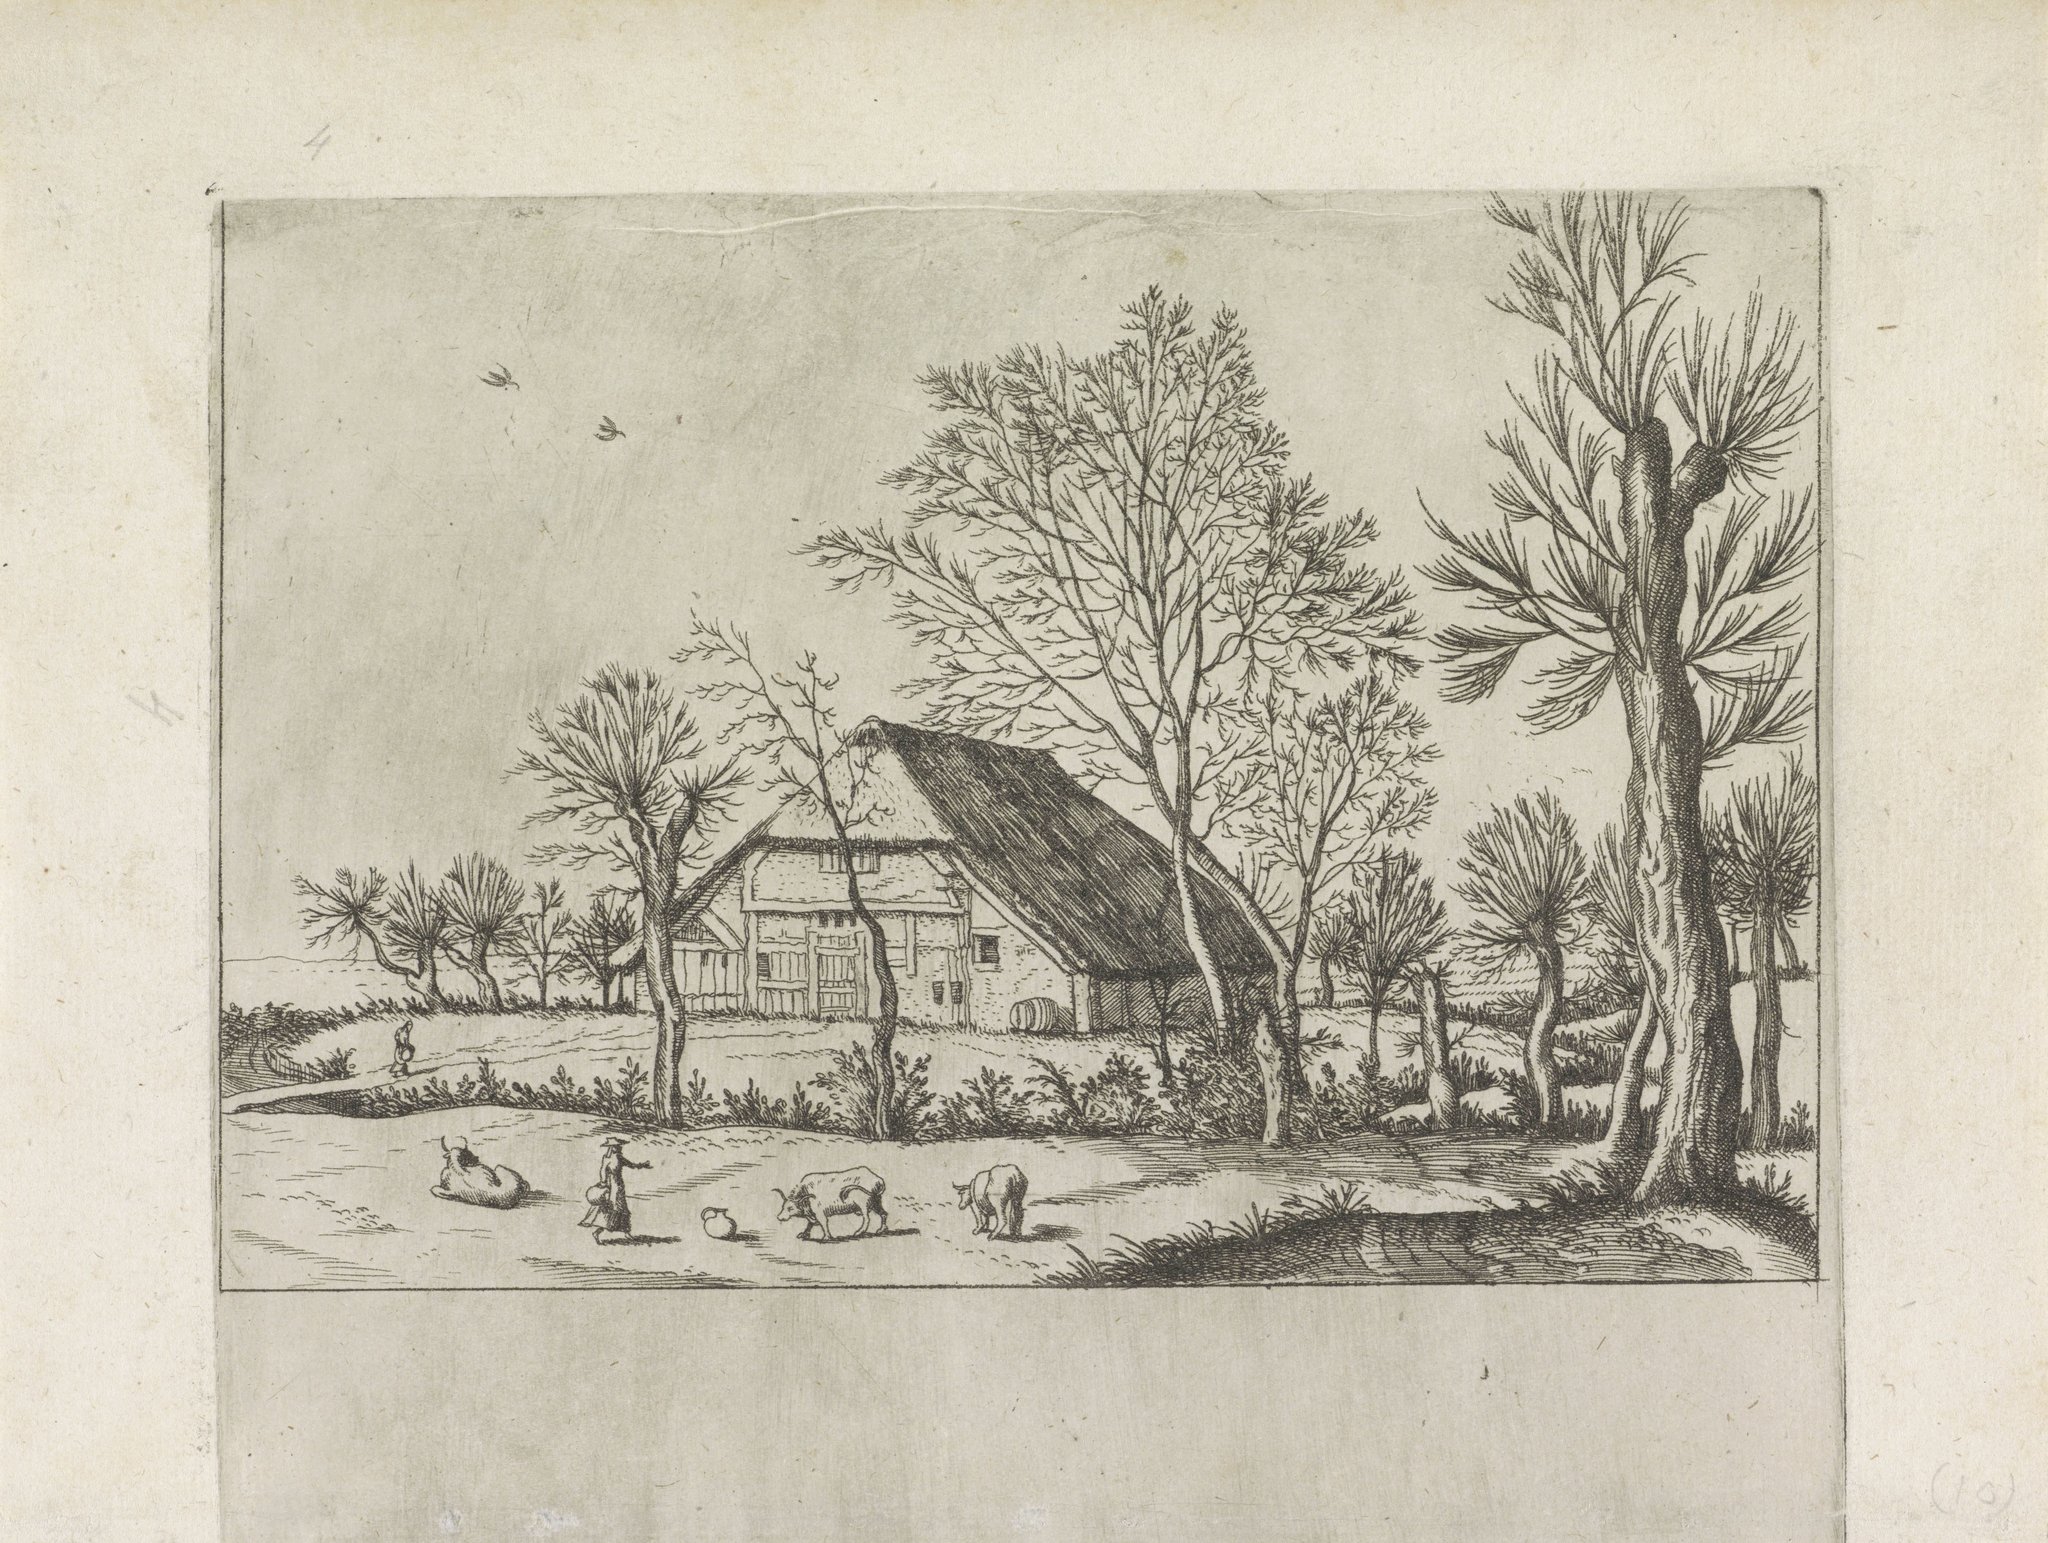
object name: print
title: Kleine landschappen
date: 1559-1561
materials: paper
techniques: etching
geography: antwerp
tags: farm (building)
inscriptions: collector's mark: Lugt 2228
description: Boerderij door bomen omringd. Op de voorgrond koeien en een melkmeid.